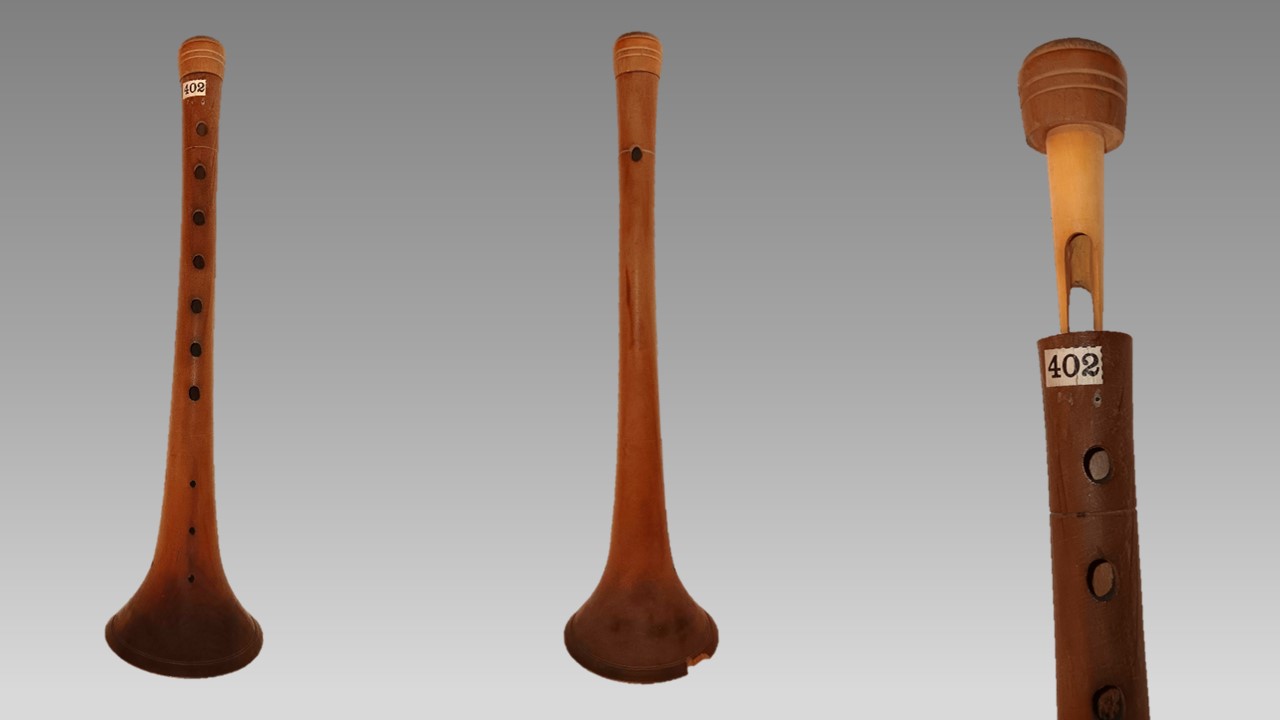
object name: riata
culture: algerian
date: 1867-1900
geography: algeria